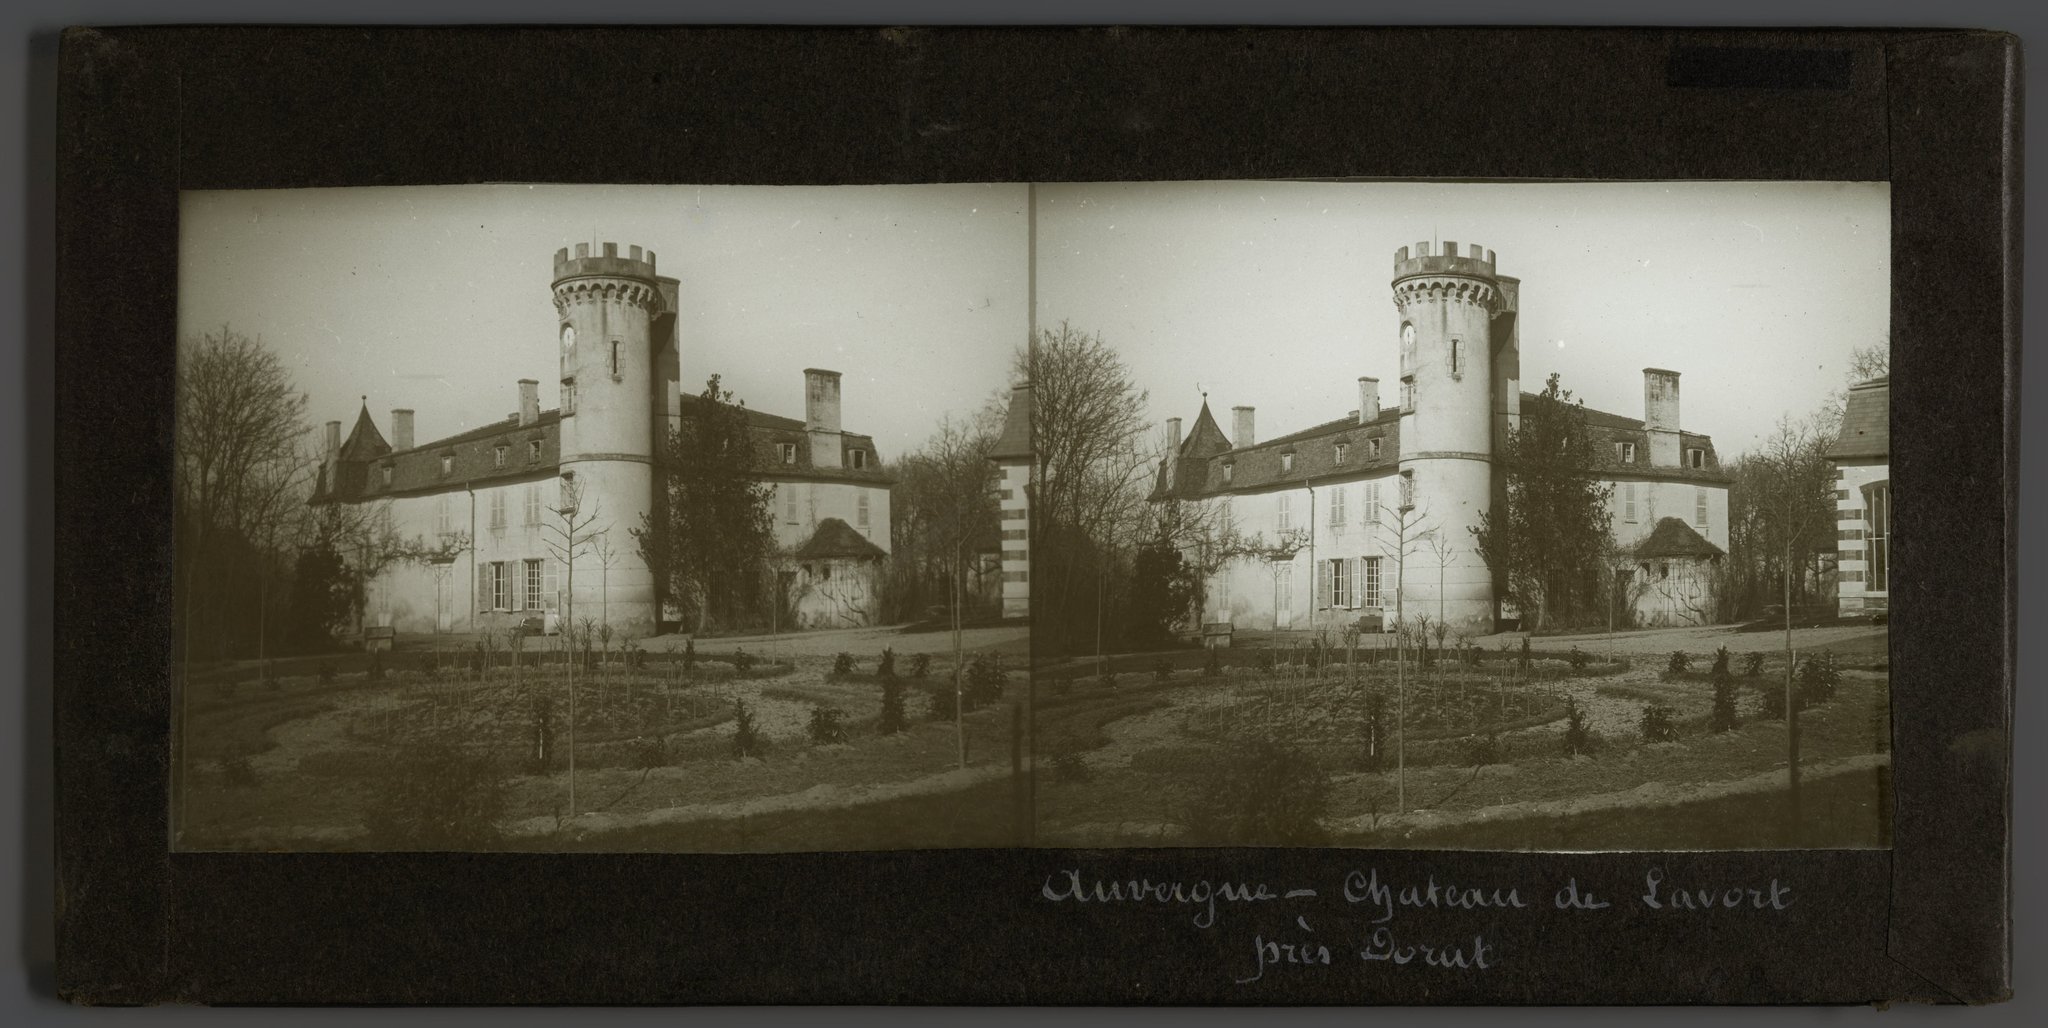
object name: stereograph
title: Auvergne - Chateau de Lavort près Dorat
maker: Anonymous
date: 1860-1890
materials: glass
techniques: slide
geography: dorat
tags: castle